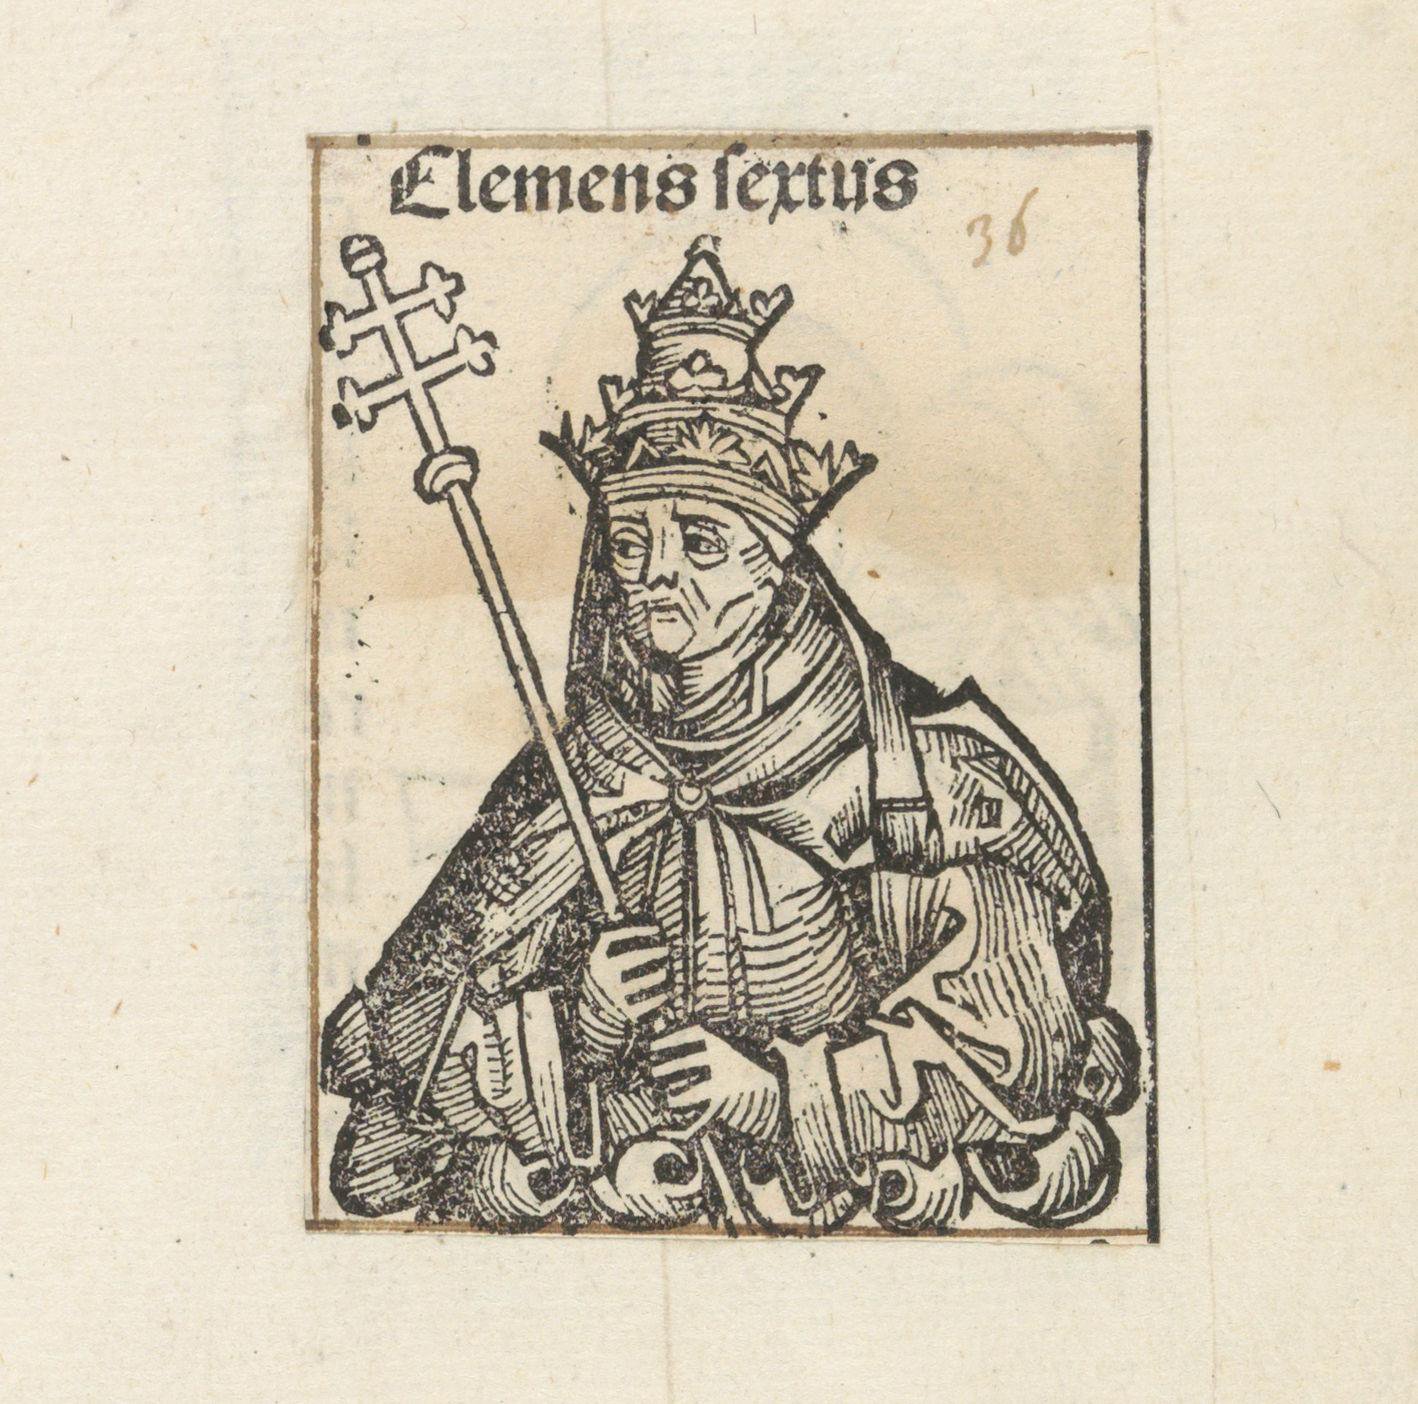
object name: album leaf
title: Liber Chronicarum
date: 1493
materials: paper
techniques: letterpress printing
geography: nuremberg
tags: pope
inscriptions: inscription: ‘36’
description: Een bloemkelk met een paus. Hij draagt een tiara en heeft een staf met een dubbel kruis in zijn handen. De voorstelling is onderdeel van de opeenvolging pausen in de Liber Chronicarum. De tekst identificeert de man als tegenpaus Clemens VII (in de titel ten onrechte Clemens VI genoemd). De prent maakt deel uit van een album.